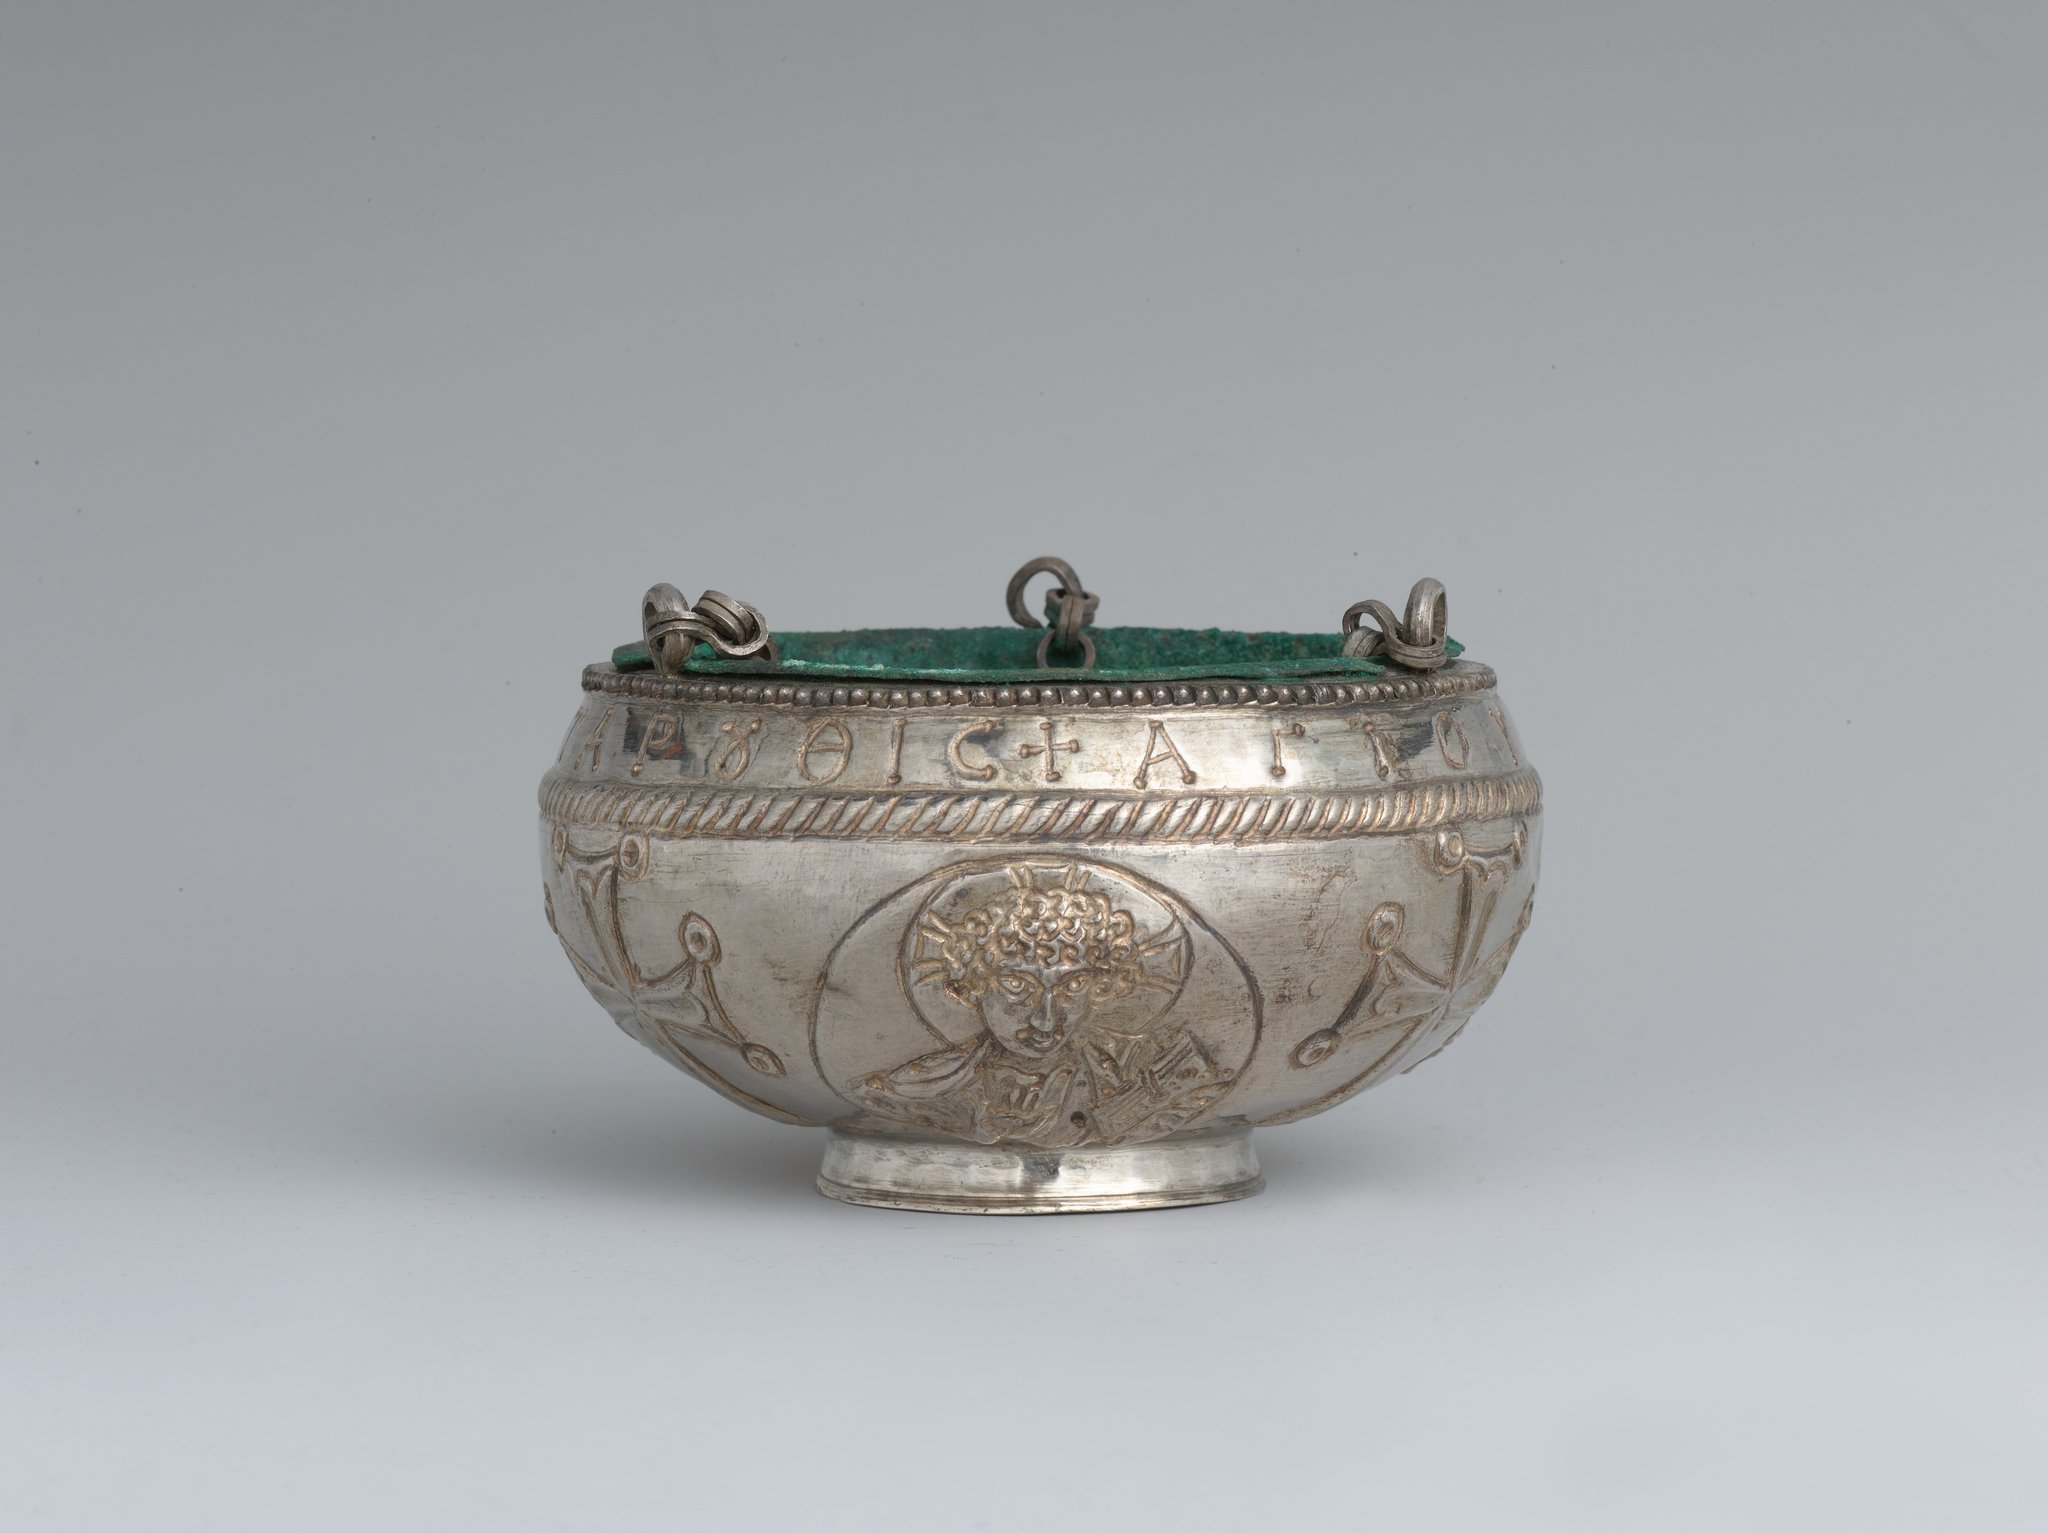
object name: censer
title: The Attarouthi Treasure - Censer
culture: byzantine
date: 500-650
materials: copper, gilt silver, silver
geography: syria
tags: angels,christ,cross